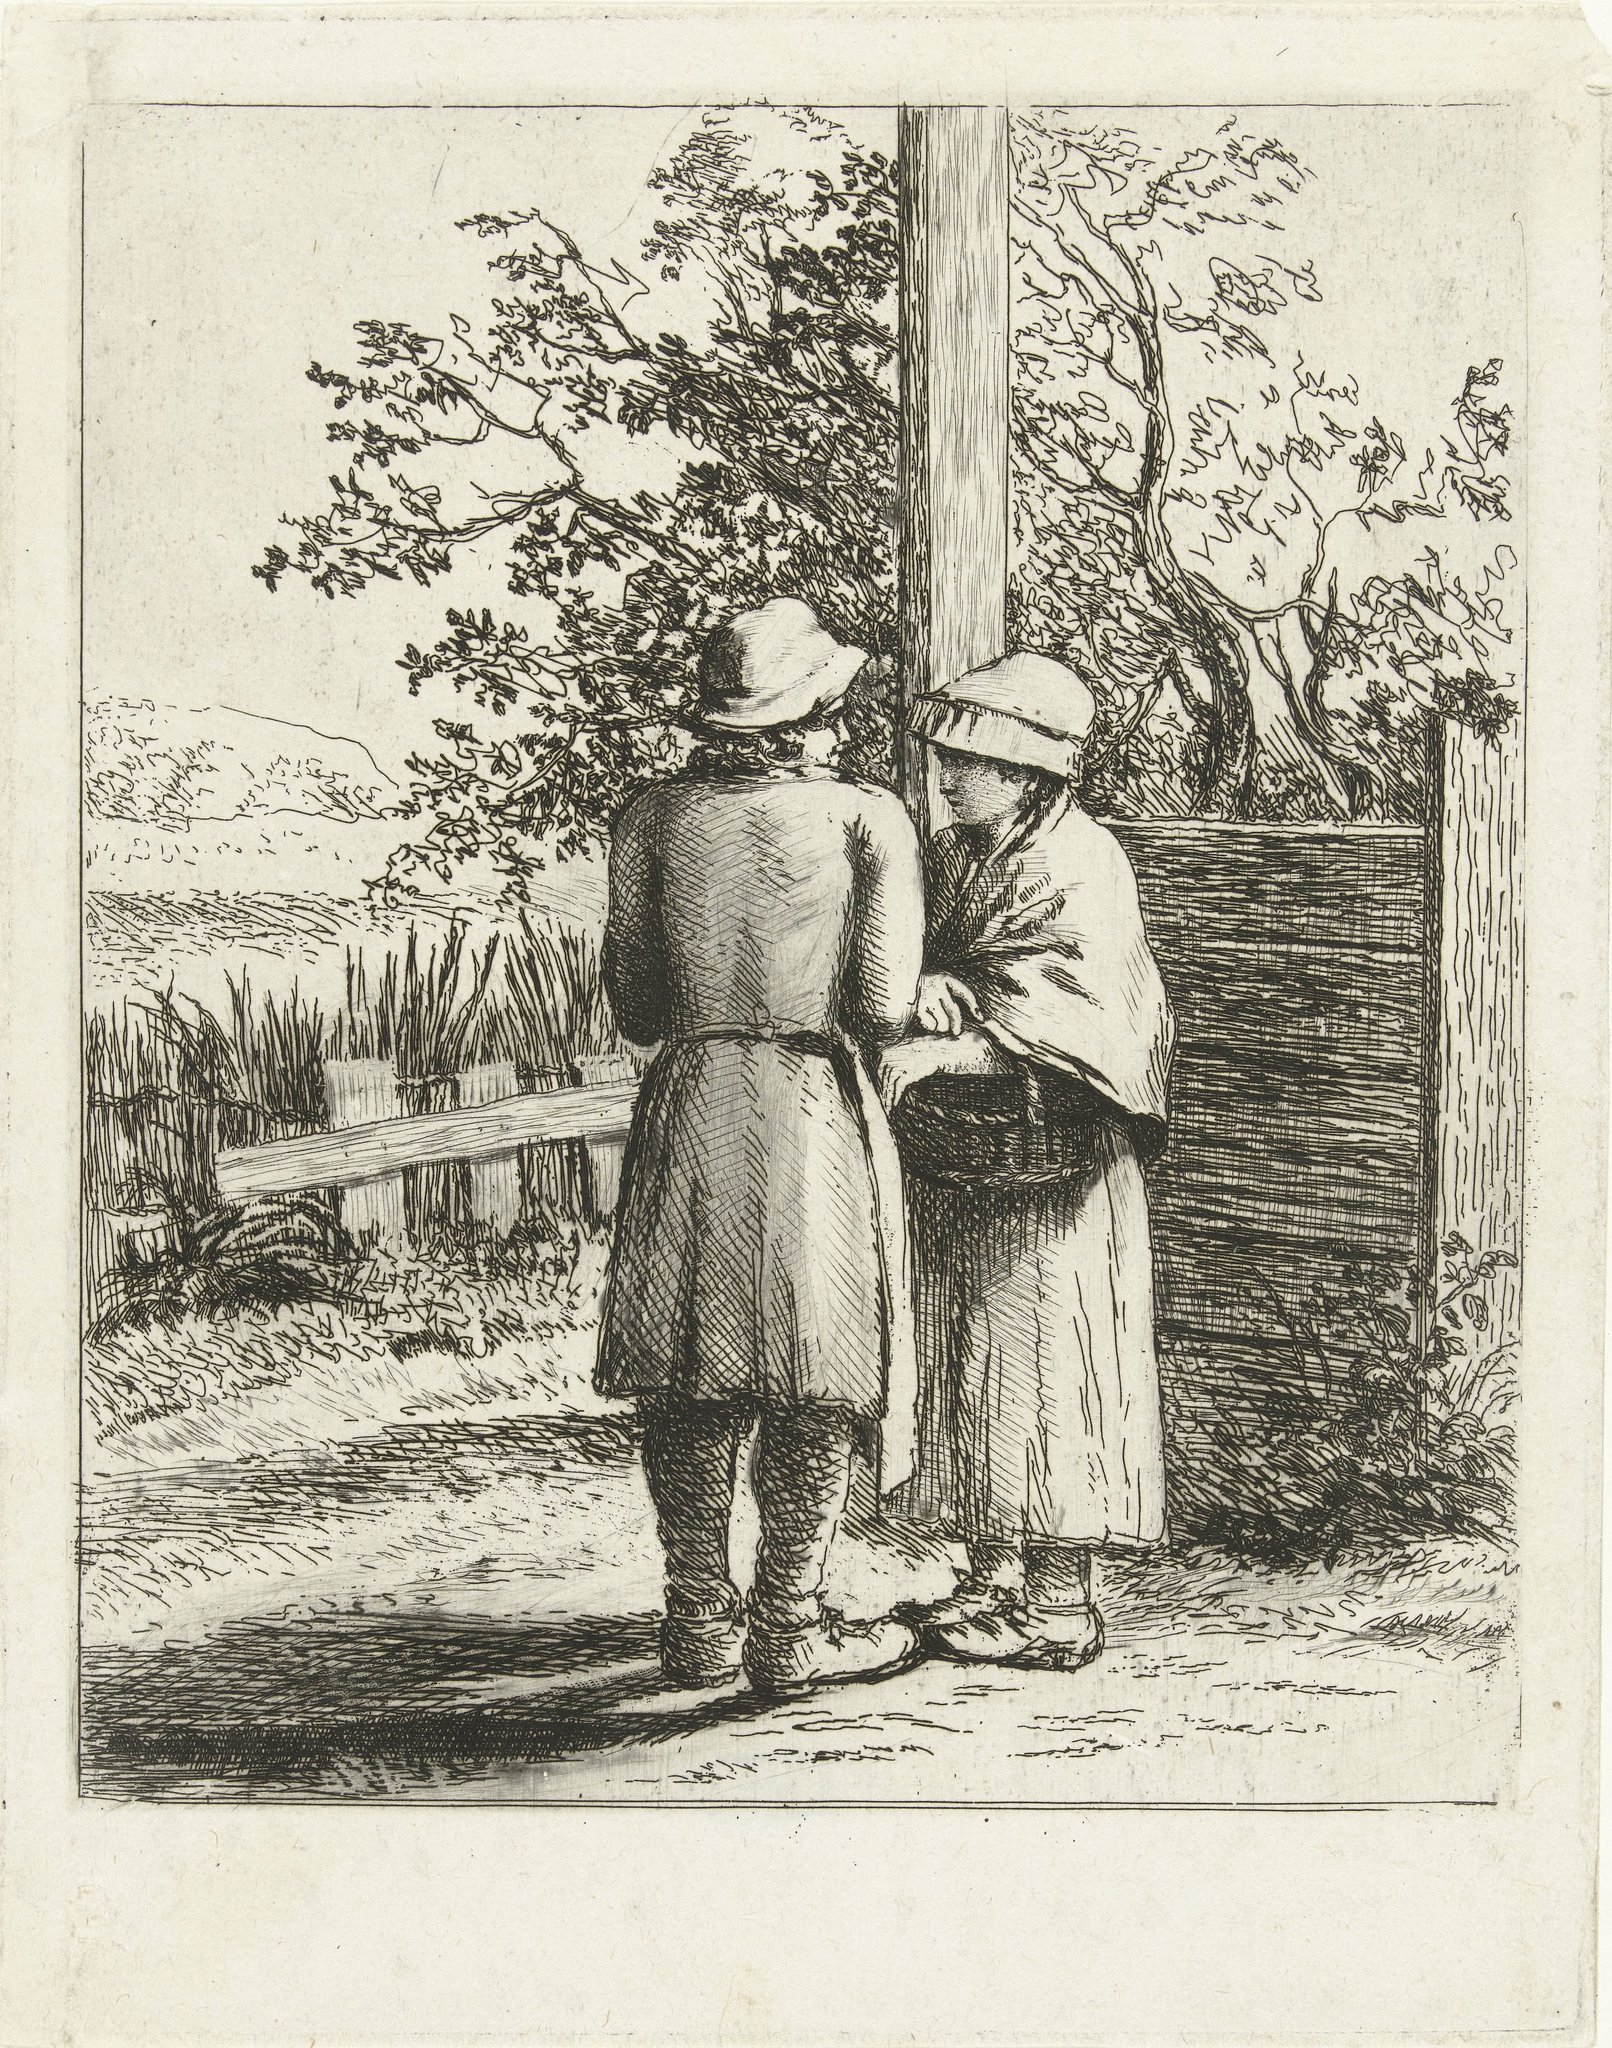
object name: print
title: Man en vrouw in gesprek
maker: louis bernard coclers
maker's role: draughtsman, print maker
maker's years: 1741-1817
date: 1756-1817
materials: paper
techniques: drypoint, etching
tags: farmers, conversation, dialogue; conversation piece, meeting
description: Een man en een vrouw met een mand praten met elkaar bij een houten hek op het veld.